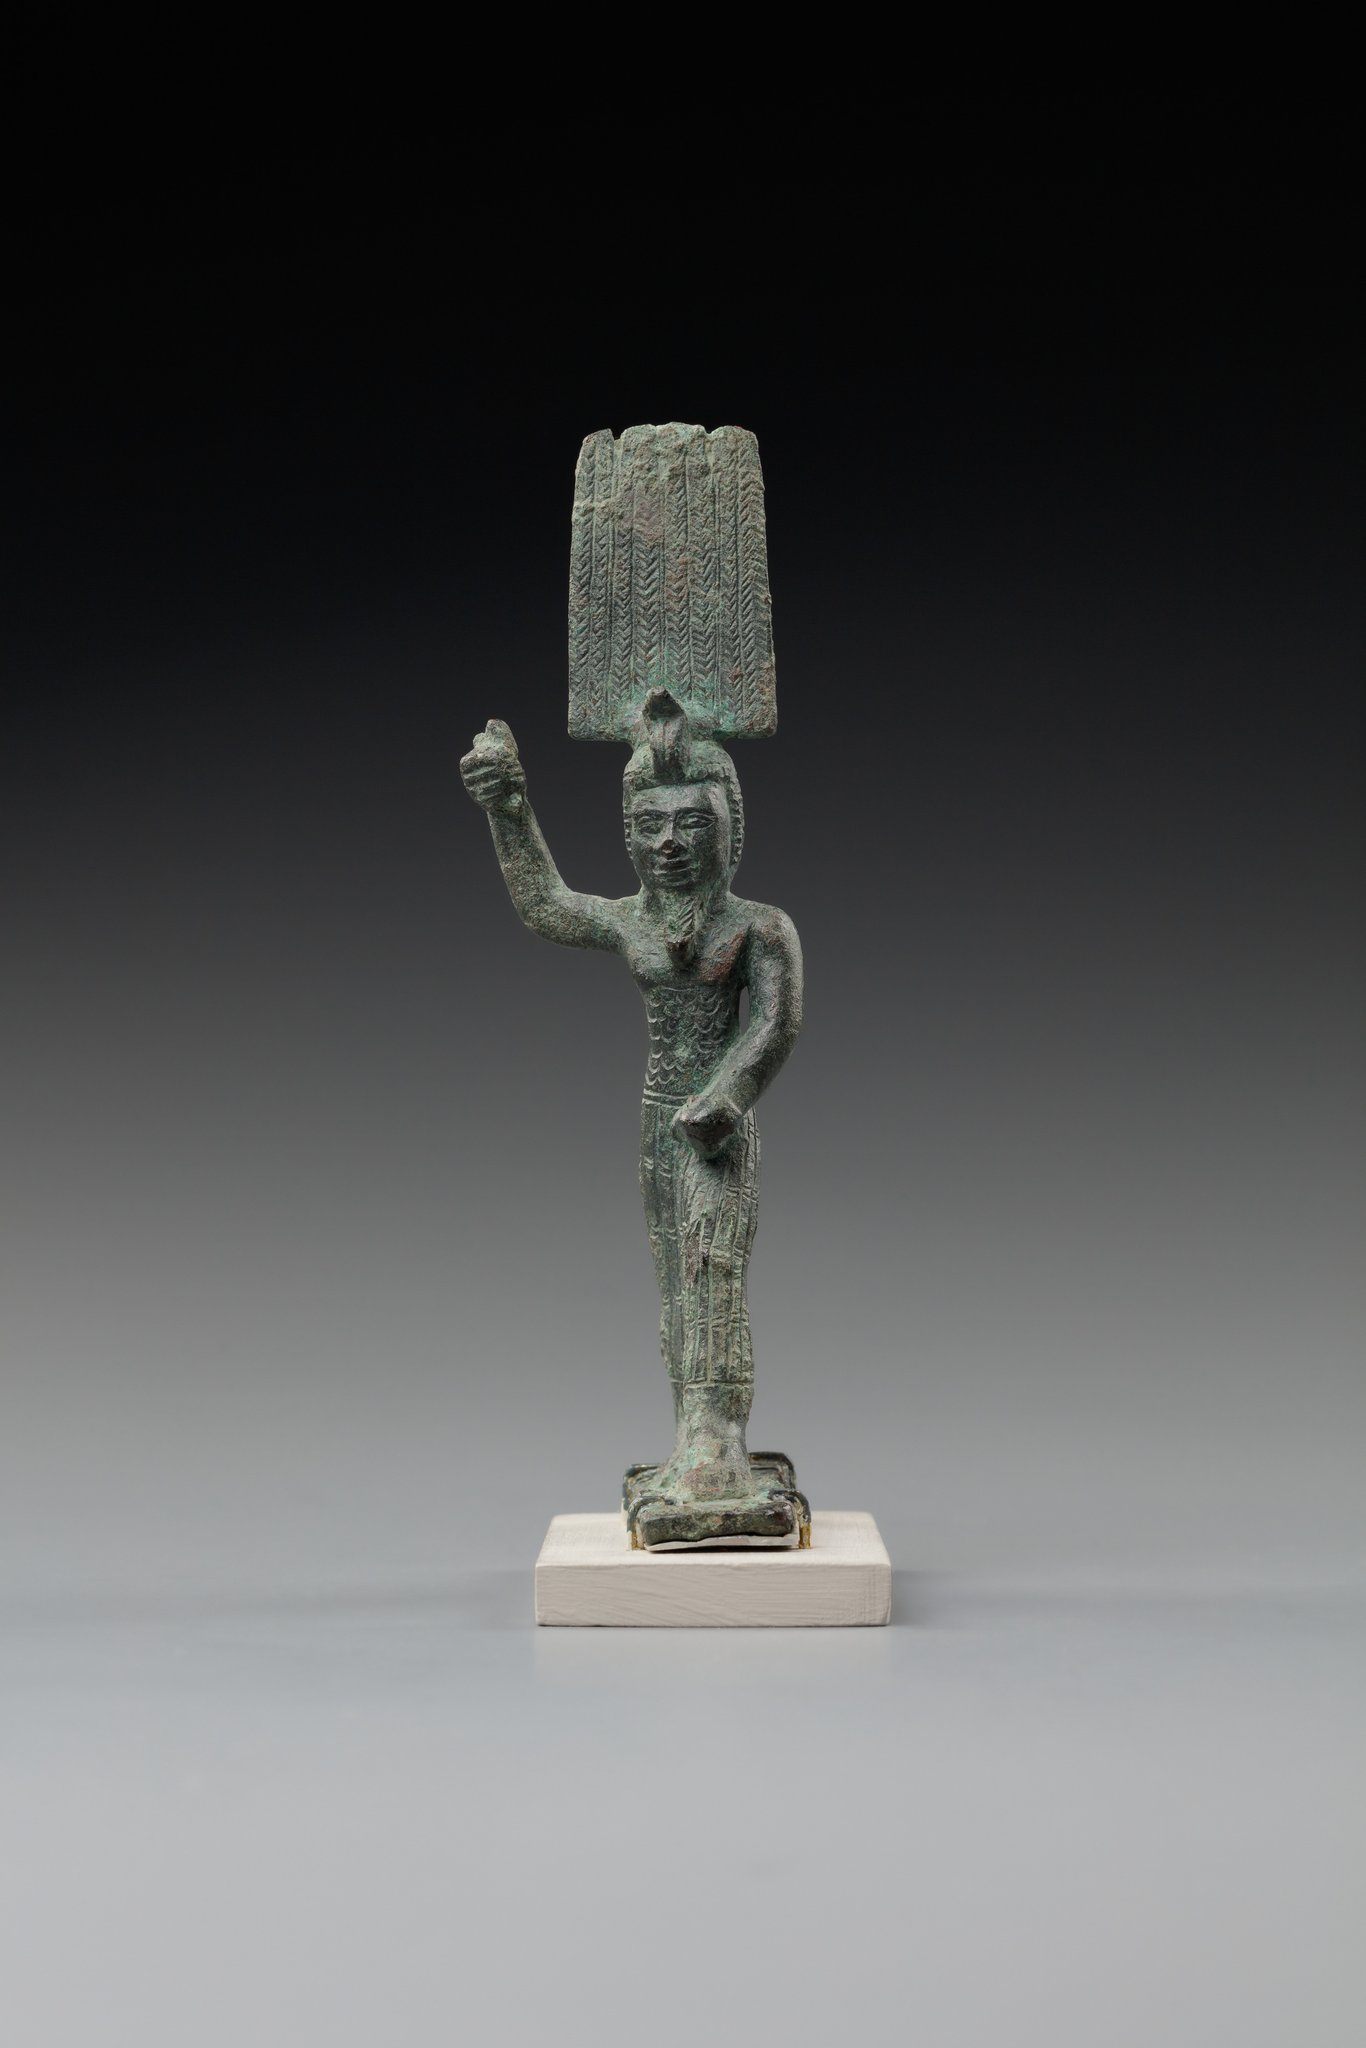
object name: statuette, onuris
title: Onuris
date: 664-630 BCE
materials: metal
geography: egypt